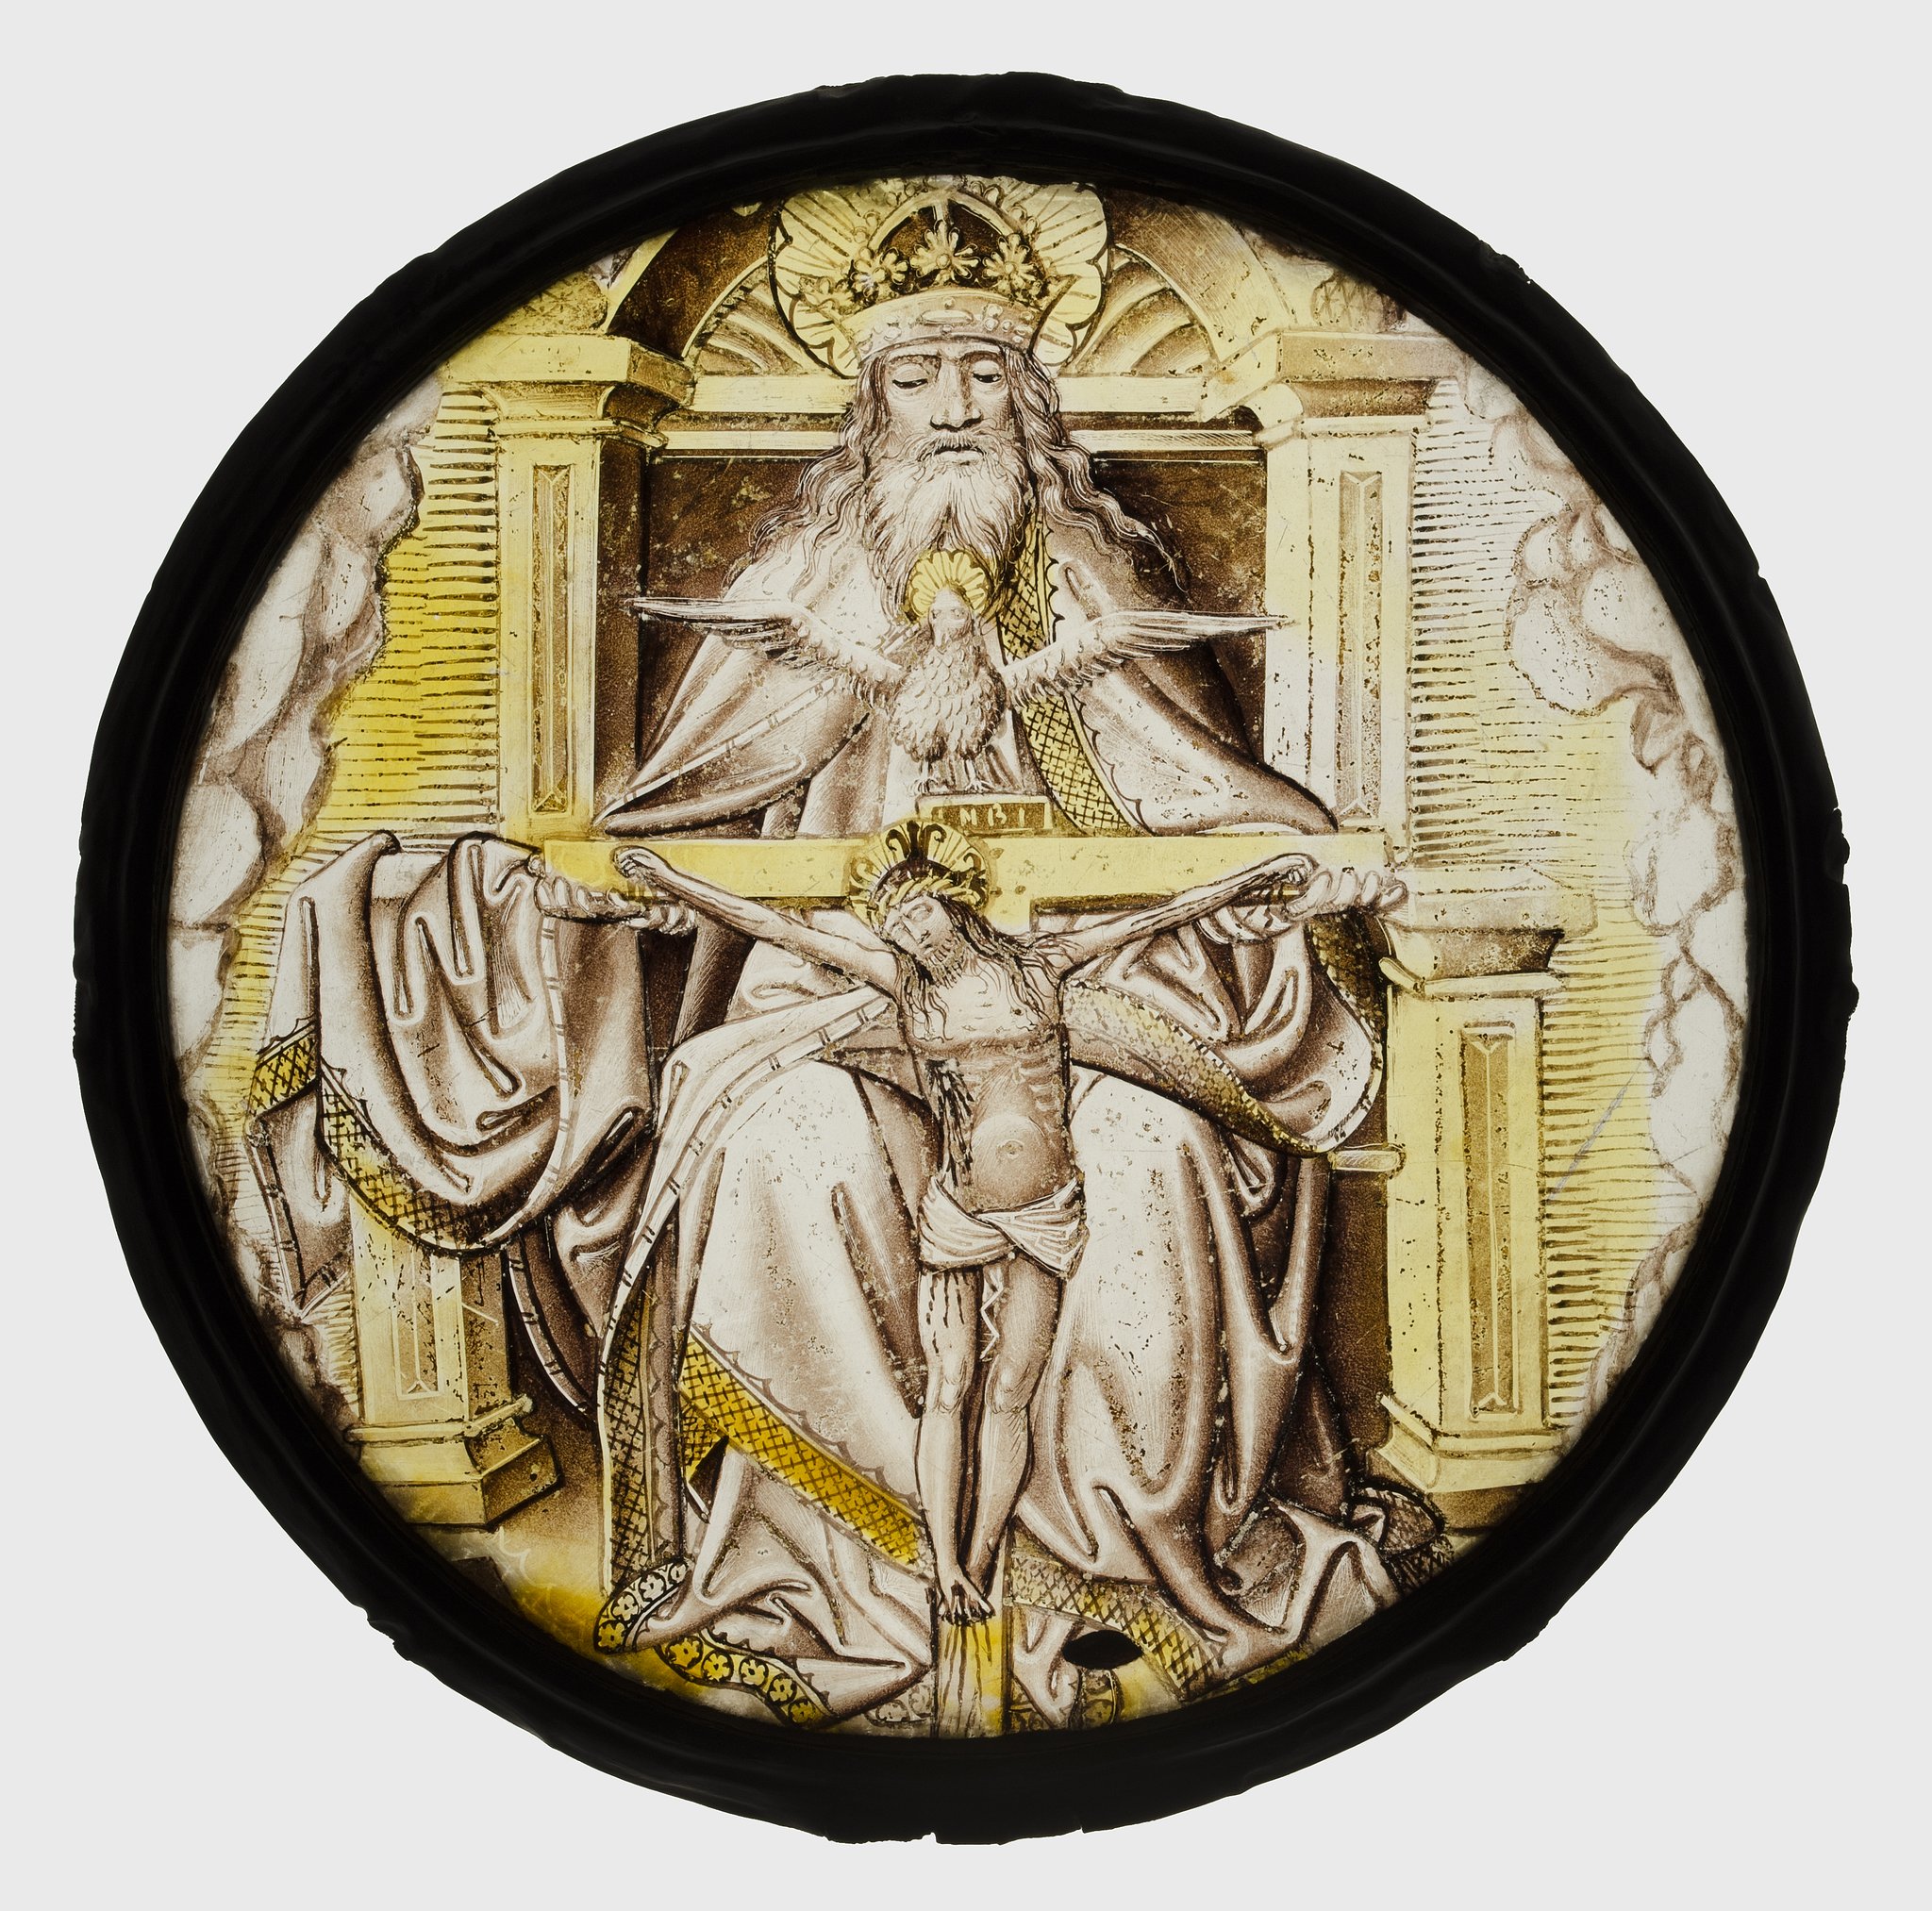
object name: roundel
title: Roundel with the Holy Trinity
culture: south netherlandish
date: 1510-1520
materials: glass, paint, pigment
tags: birds,christ,cross,crucifixion